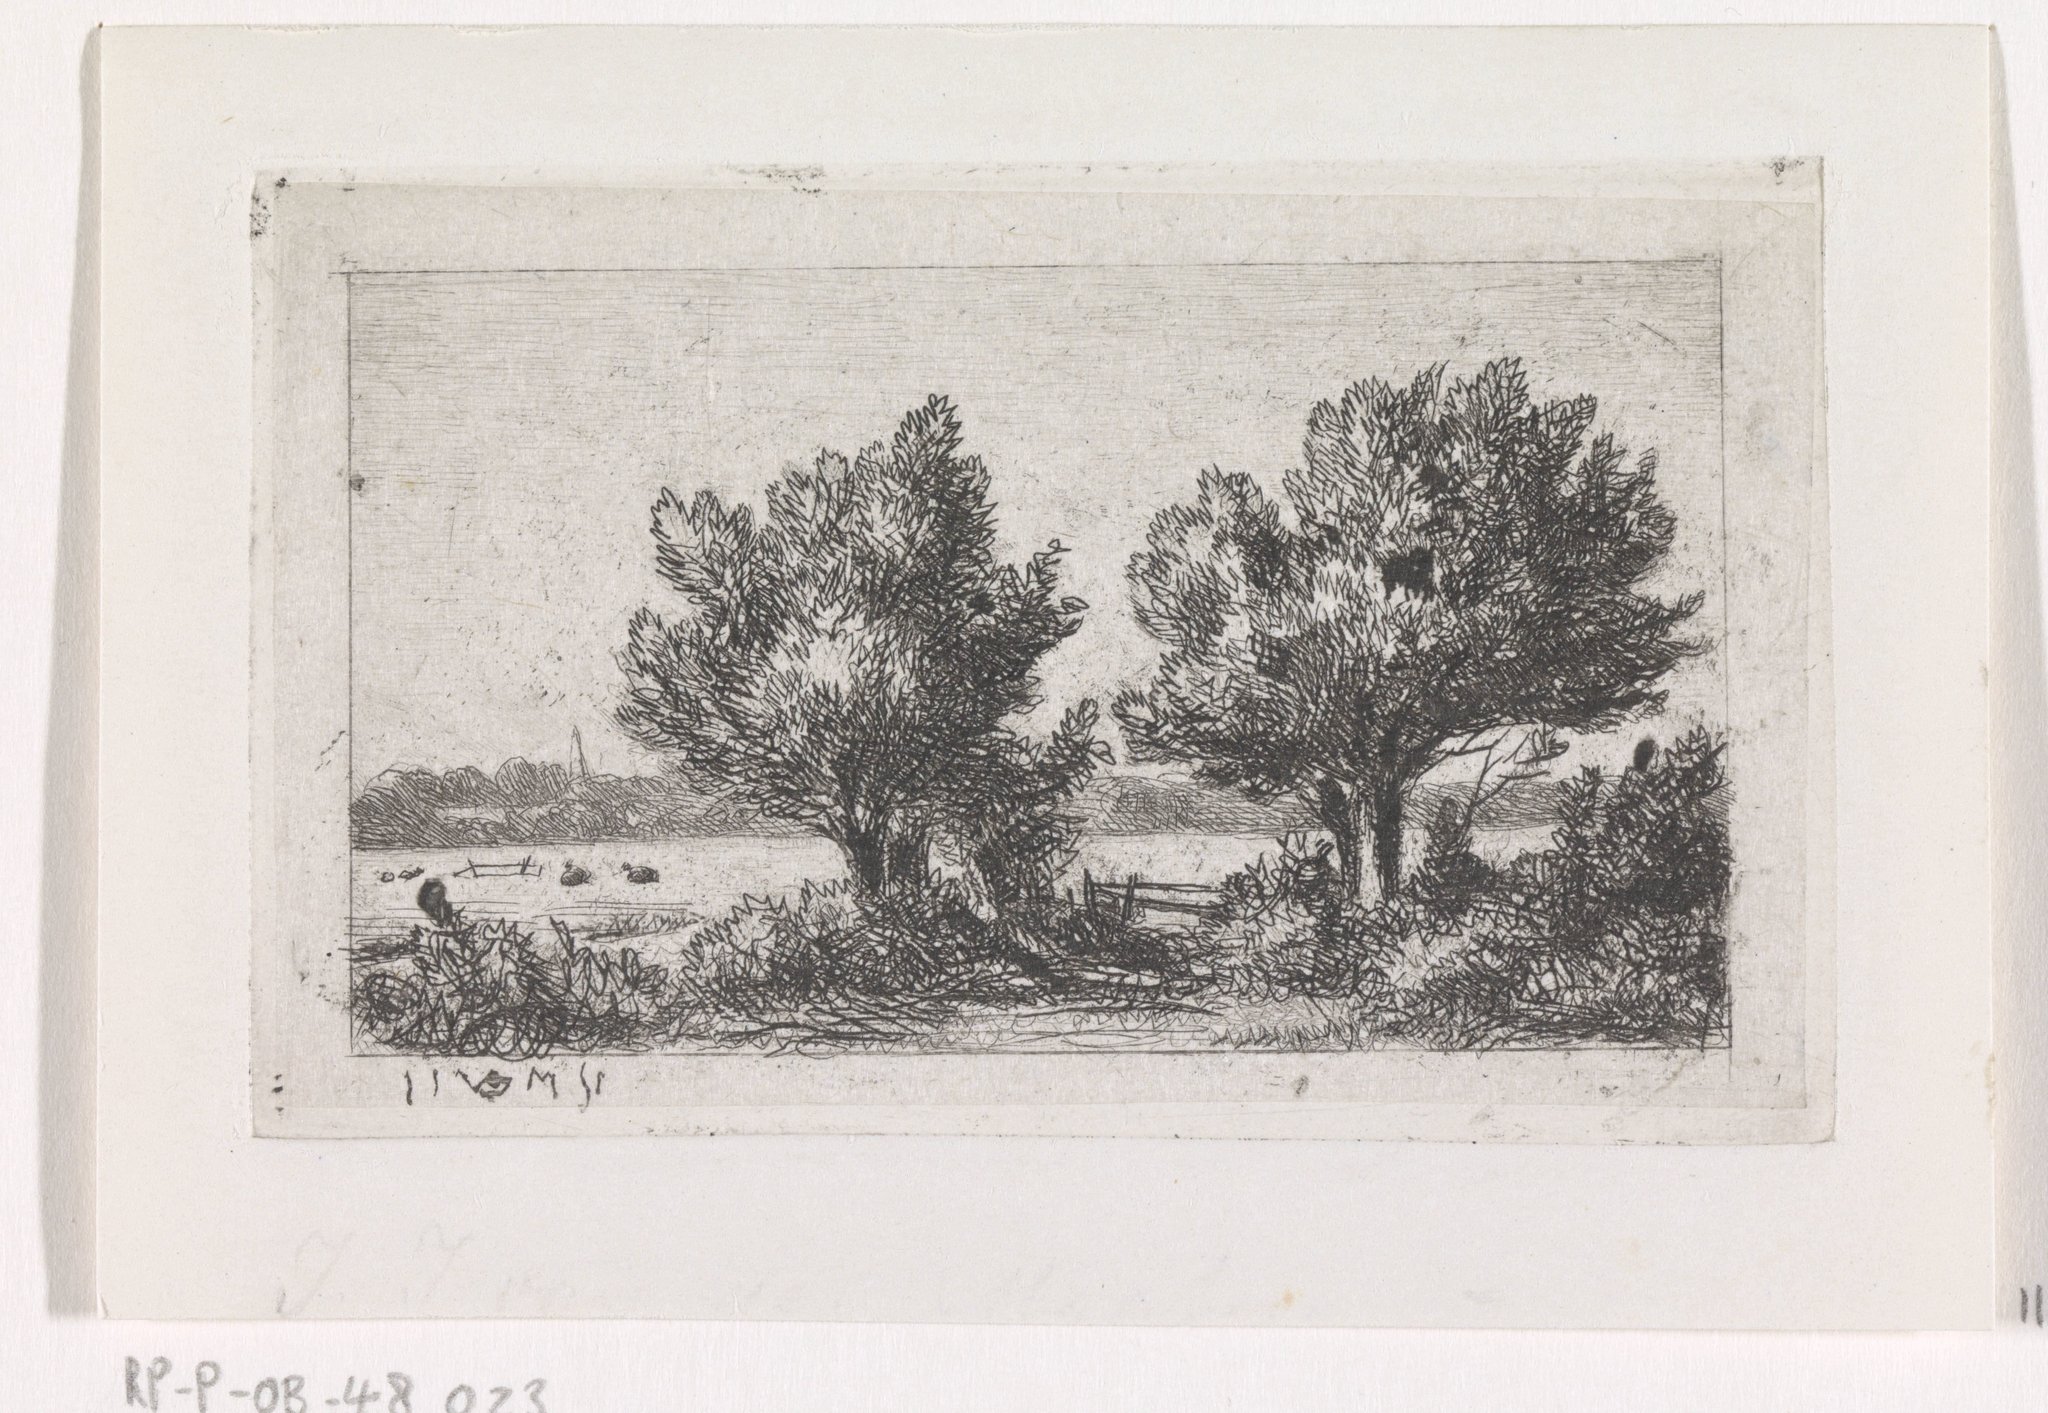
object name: print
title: Bomen in een weidelandschap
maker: jacob jan van der maaten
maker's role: draughtsman, print maker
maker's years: 1820-1879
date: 1851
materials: paper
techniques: etching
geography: the hague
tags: trees, meadow, pasture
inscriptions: collector's mark: Lugt 2228